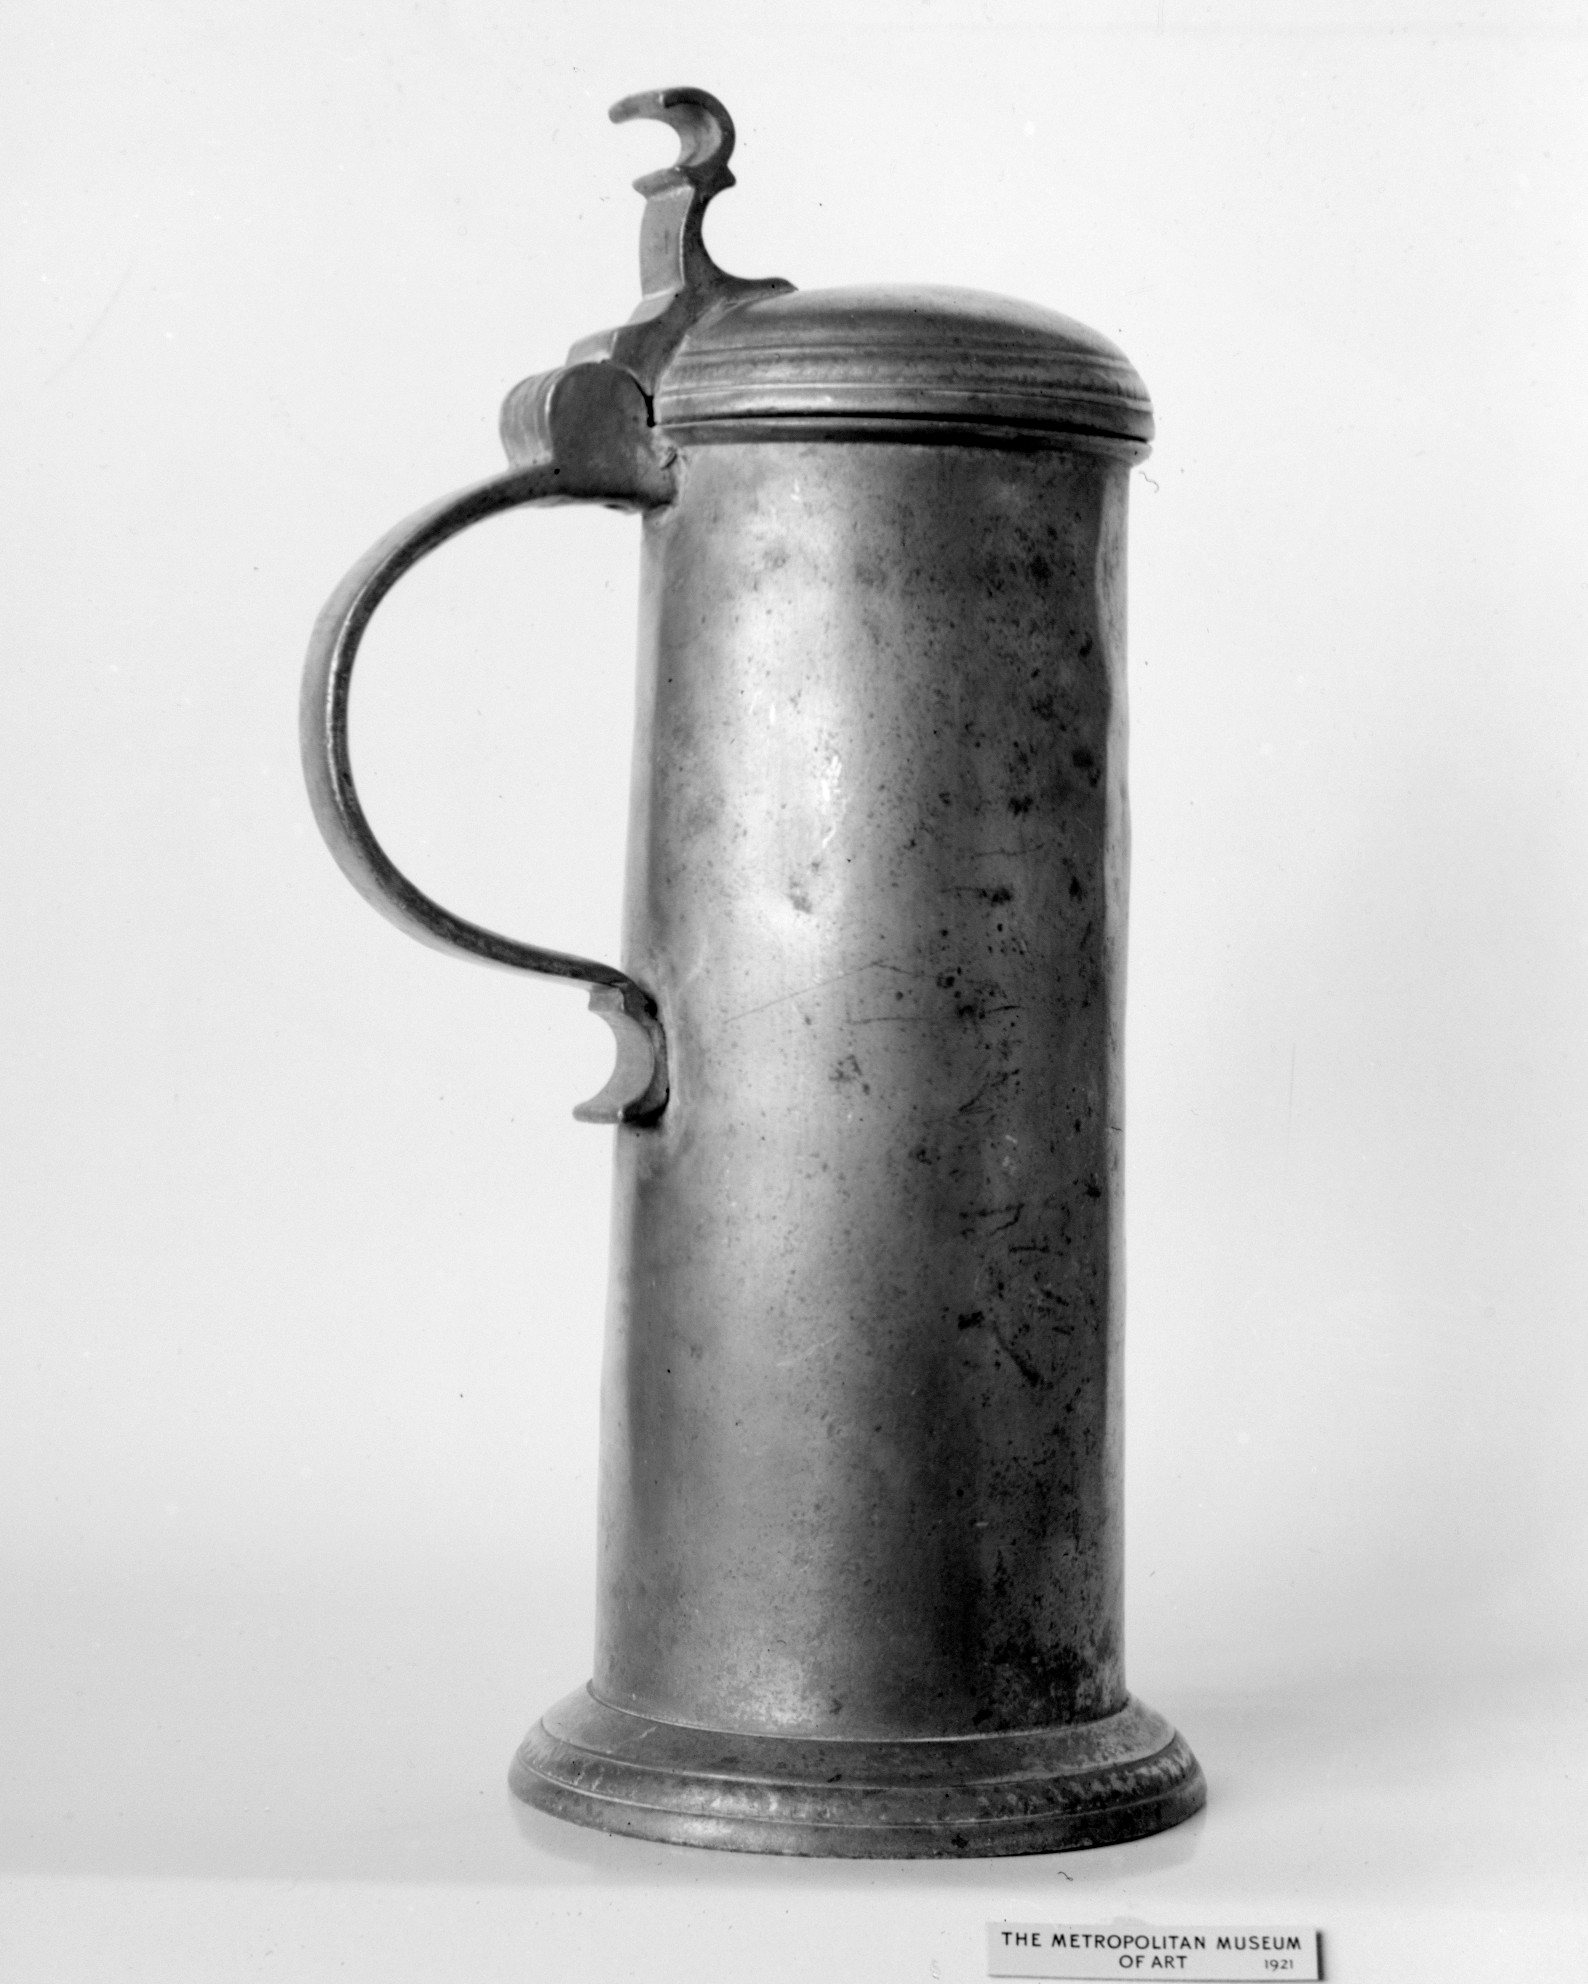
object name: tankard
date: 1601-1800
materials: pewter